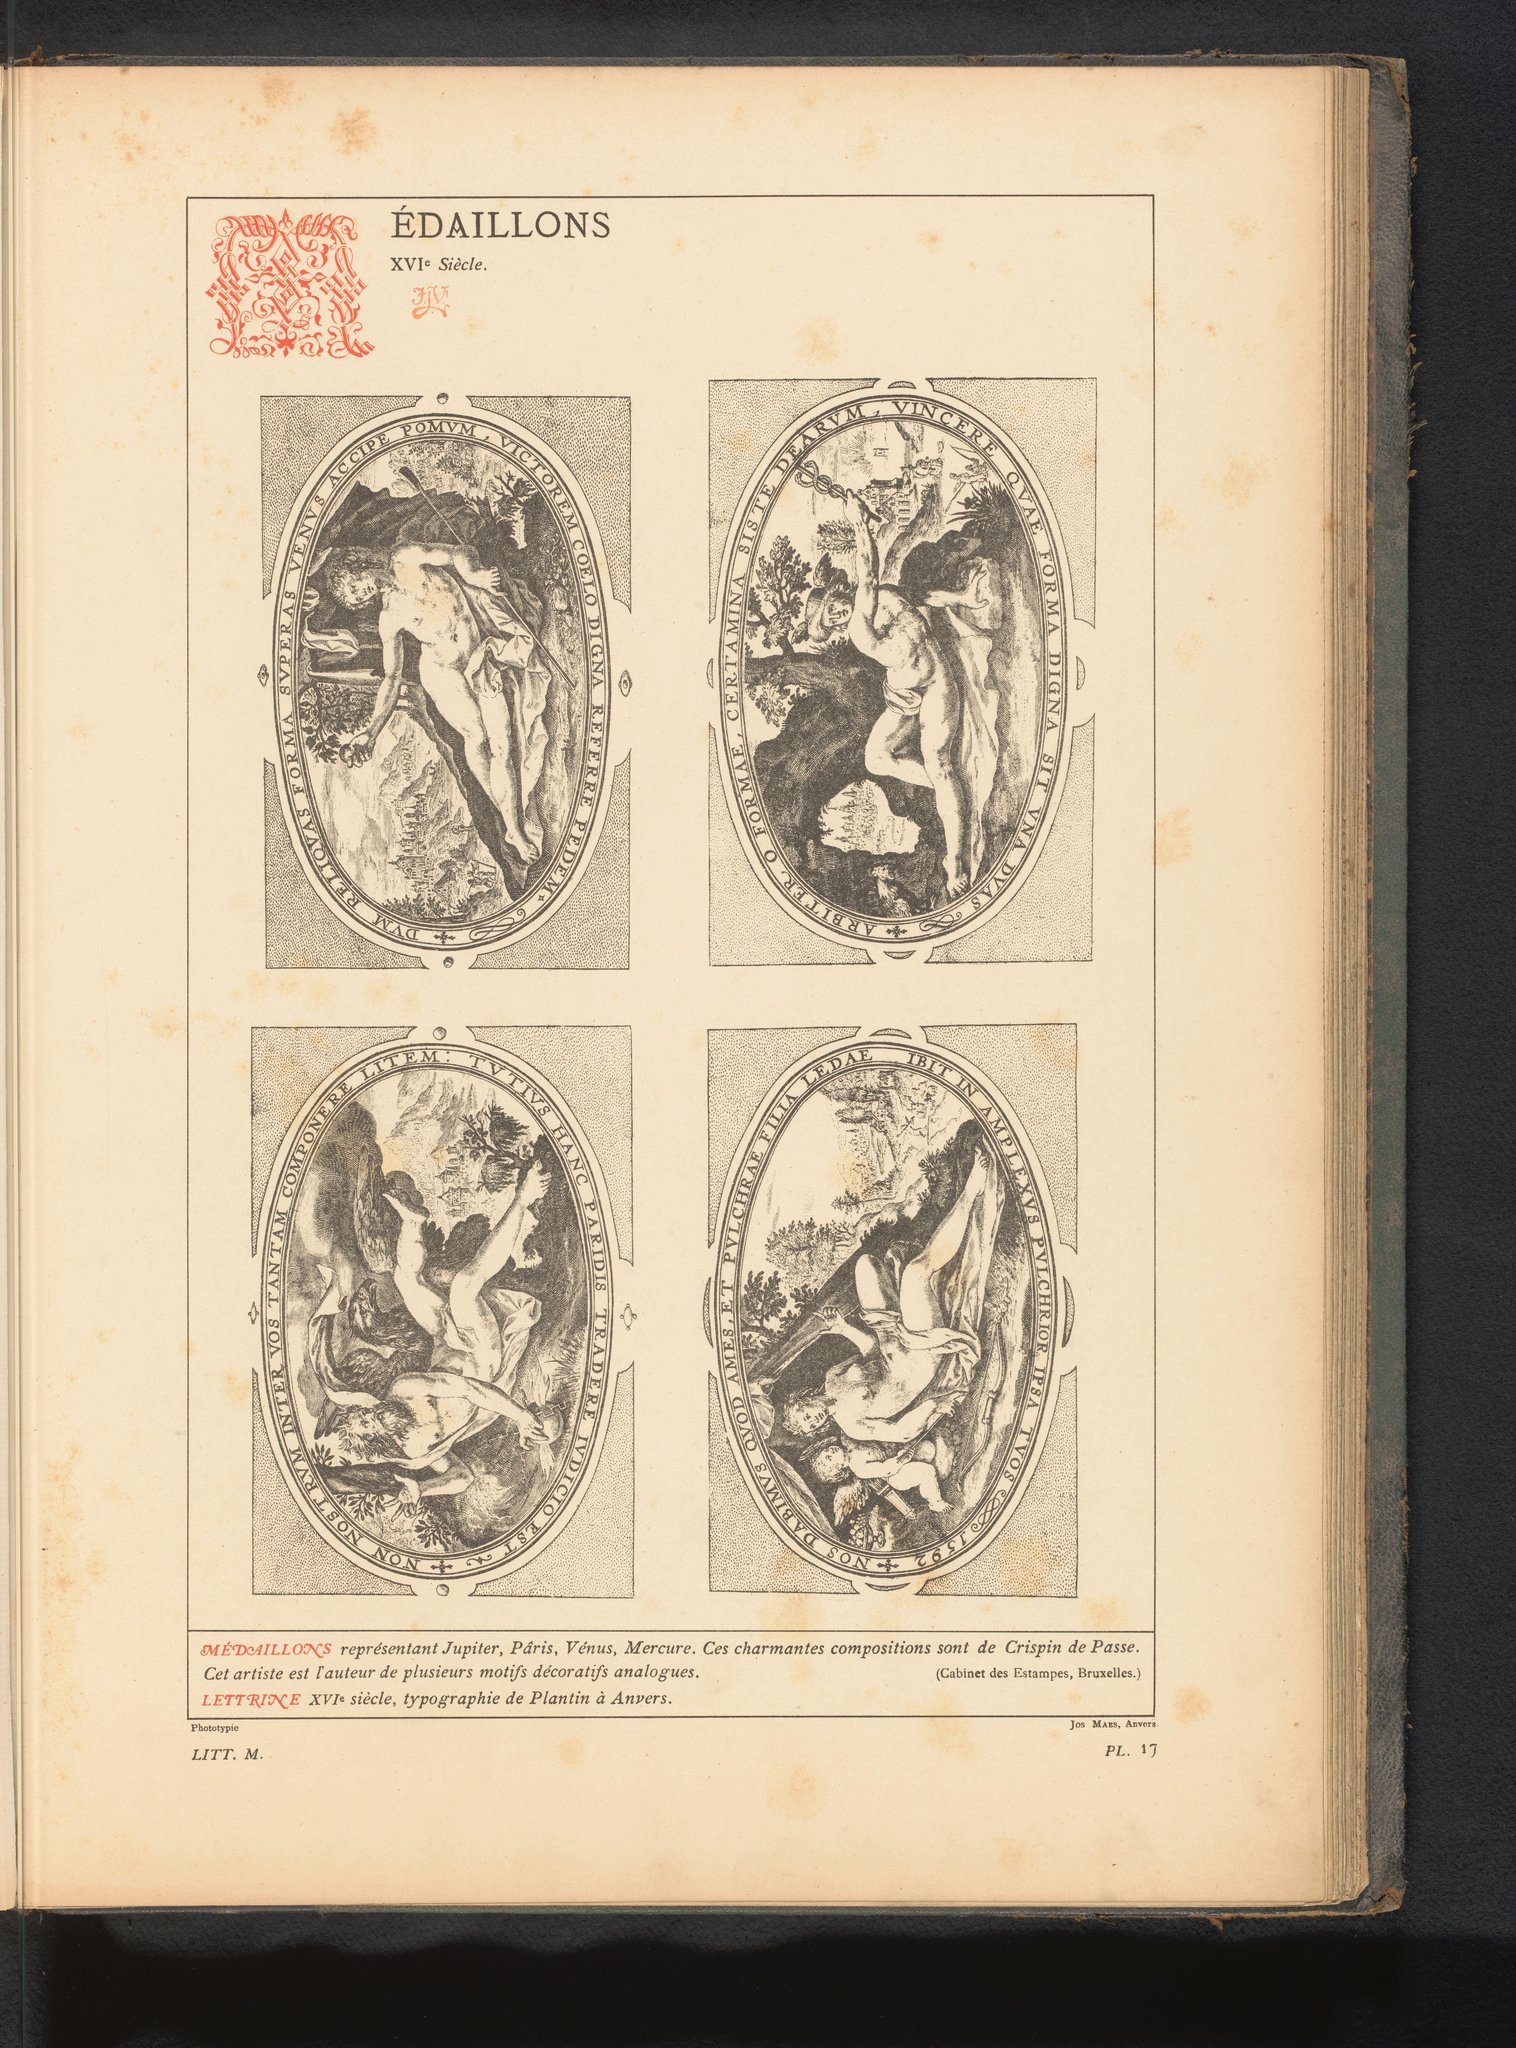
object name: page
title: Médaillons, XVIe Siècle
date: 1875-1880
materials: paper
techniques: photolithography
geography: antwerp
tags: (story of) mercury (hermes), ornament ~ medallion, (story of) jupiter (zeus), (story of) venus (aphrodite), (story of) paris (alexander)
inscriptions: inscription: ‘LITT. M. - PL. 17’, monogram: ‘JJvY’, inscription: ‘MÉDAILLONS représentant Jupiter (...)’